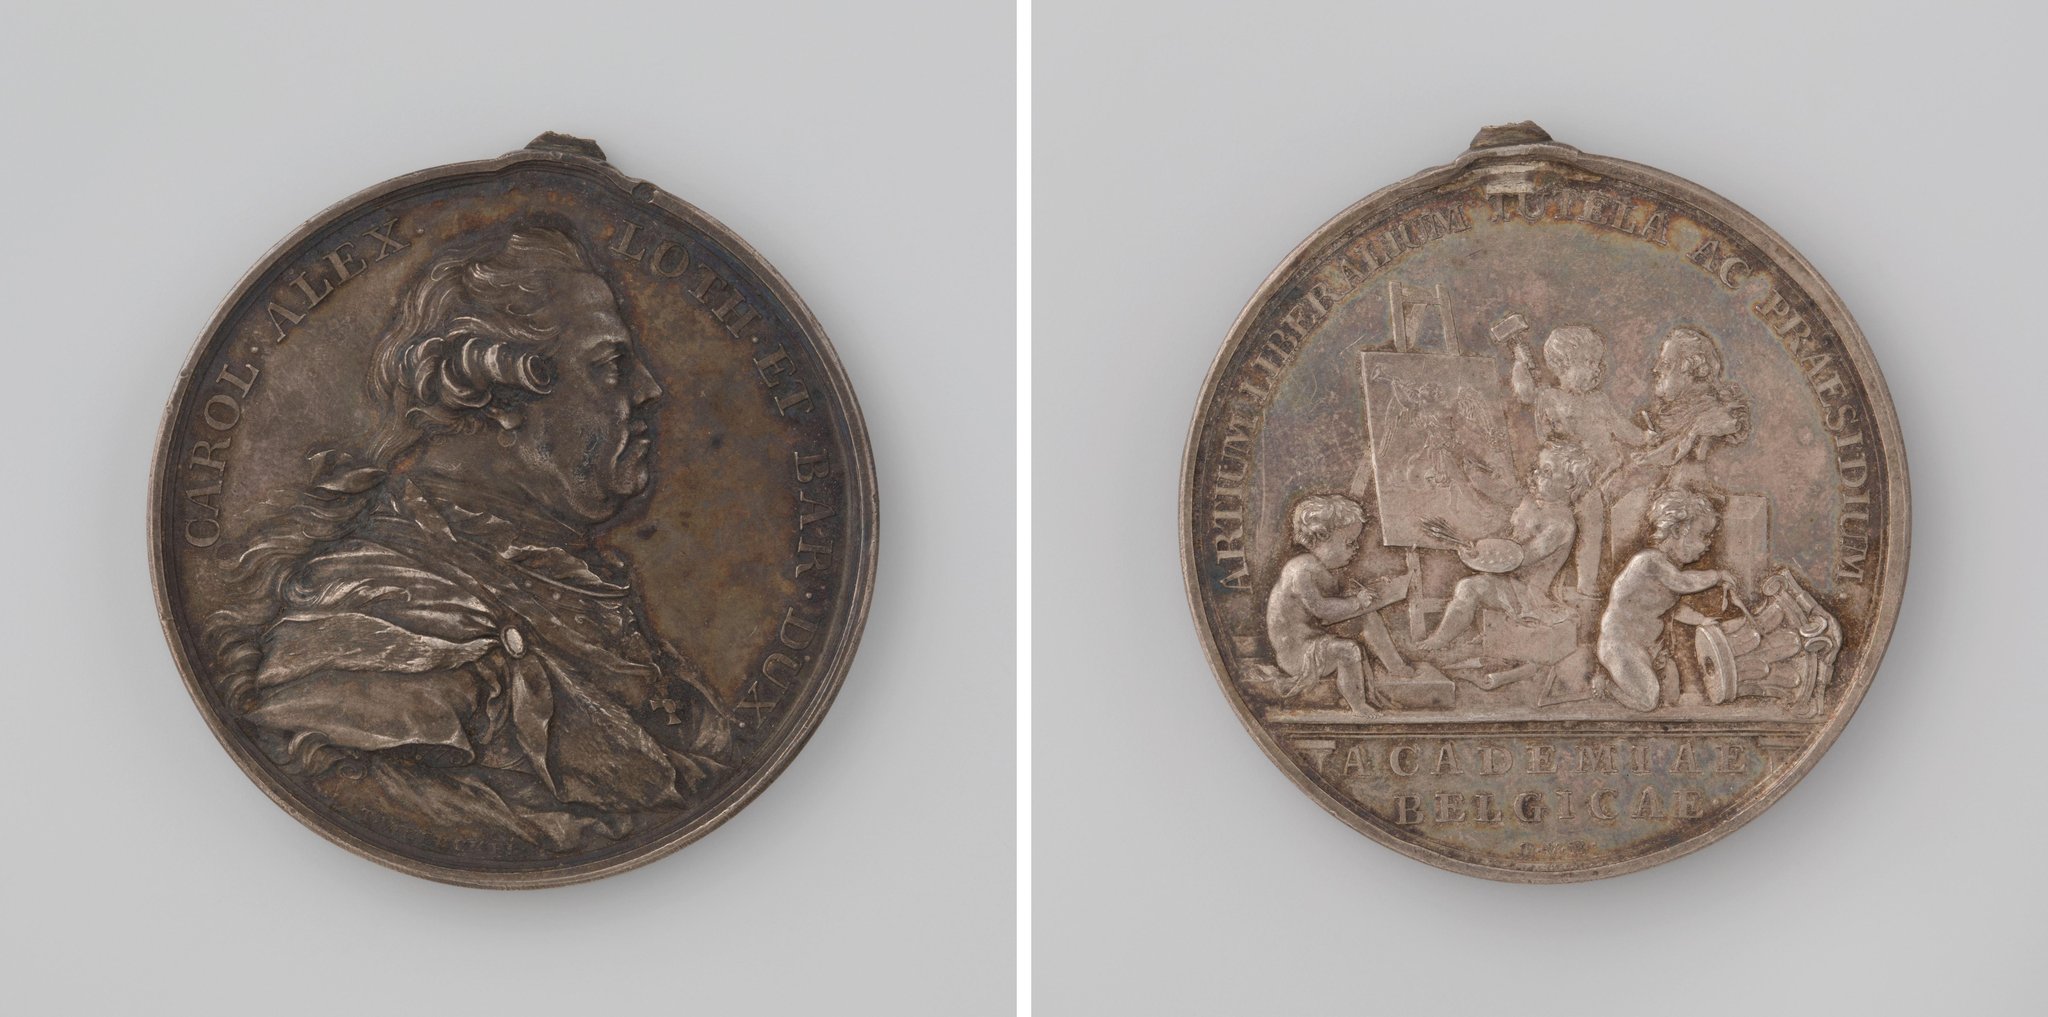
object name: history medal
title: Stichting van de Belgische Teeken-academie, ter ere van Karel Alexander, hertog van Lotharingen-Bar, beschermheer der vrije kunsten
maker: theodorus victor van berckel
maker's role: mintmaster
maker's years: 1739-1808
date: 1778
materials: silver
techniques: striking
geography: brussels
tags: karel alexander hertog van lotharingen, brussels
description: Zilveren penning met afgebroken draagoog. Voorzijde: borststuk man binnen omschrift. Keerzijde: vier genii die zich bezighouden met teken-, schilder-, beeldhouw- en bouwkunst binnen omschrift; afsnede: opschrift